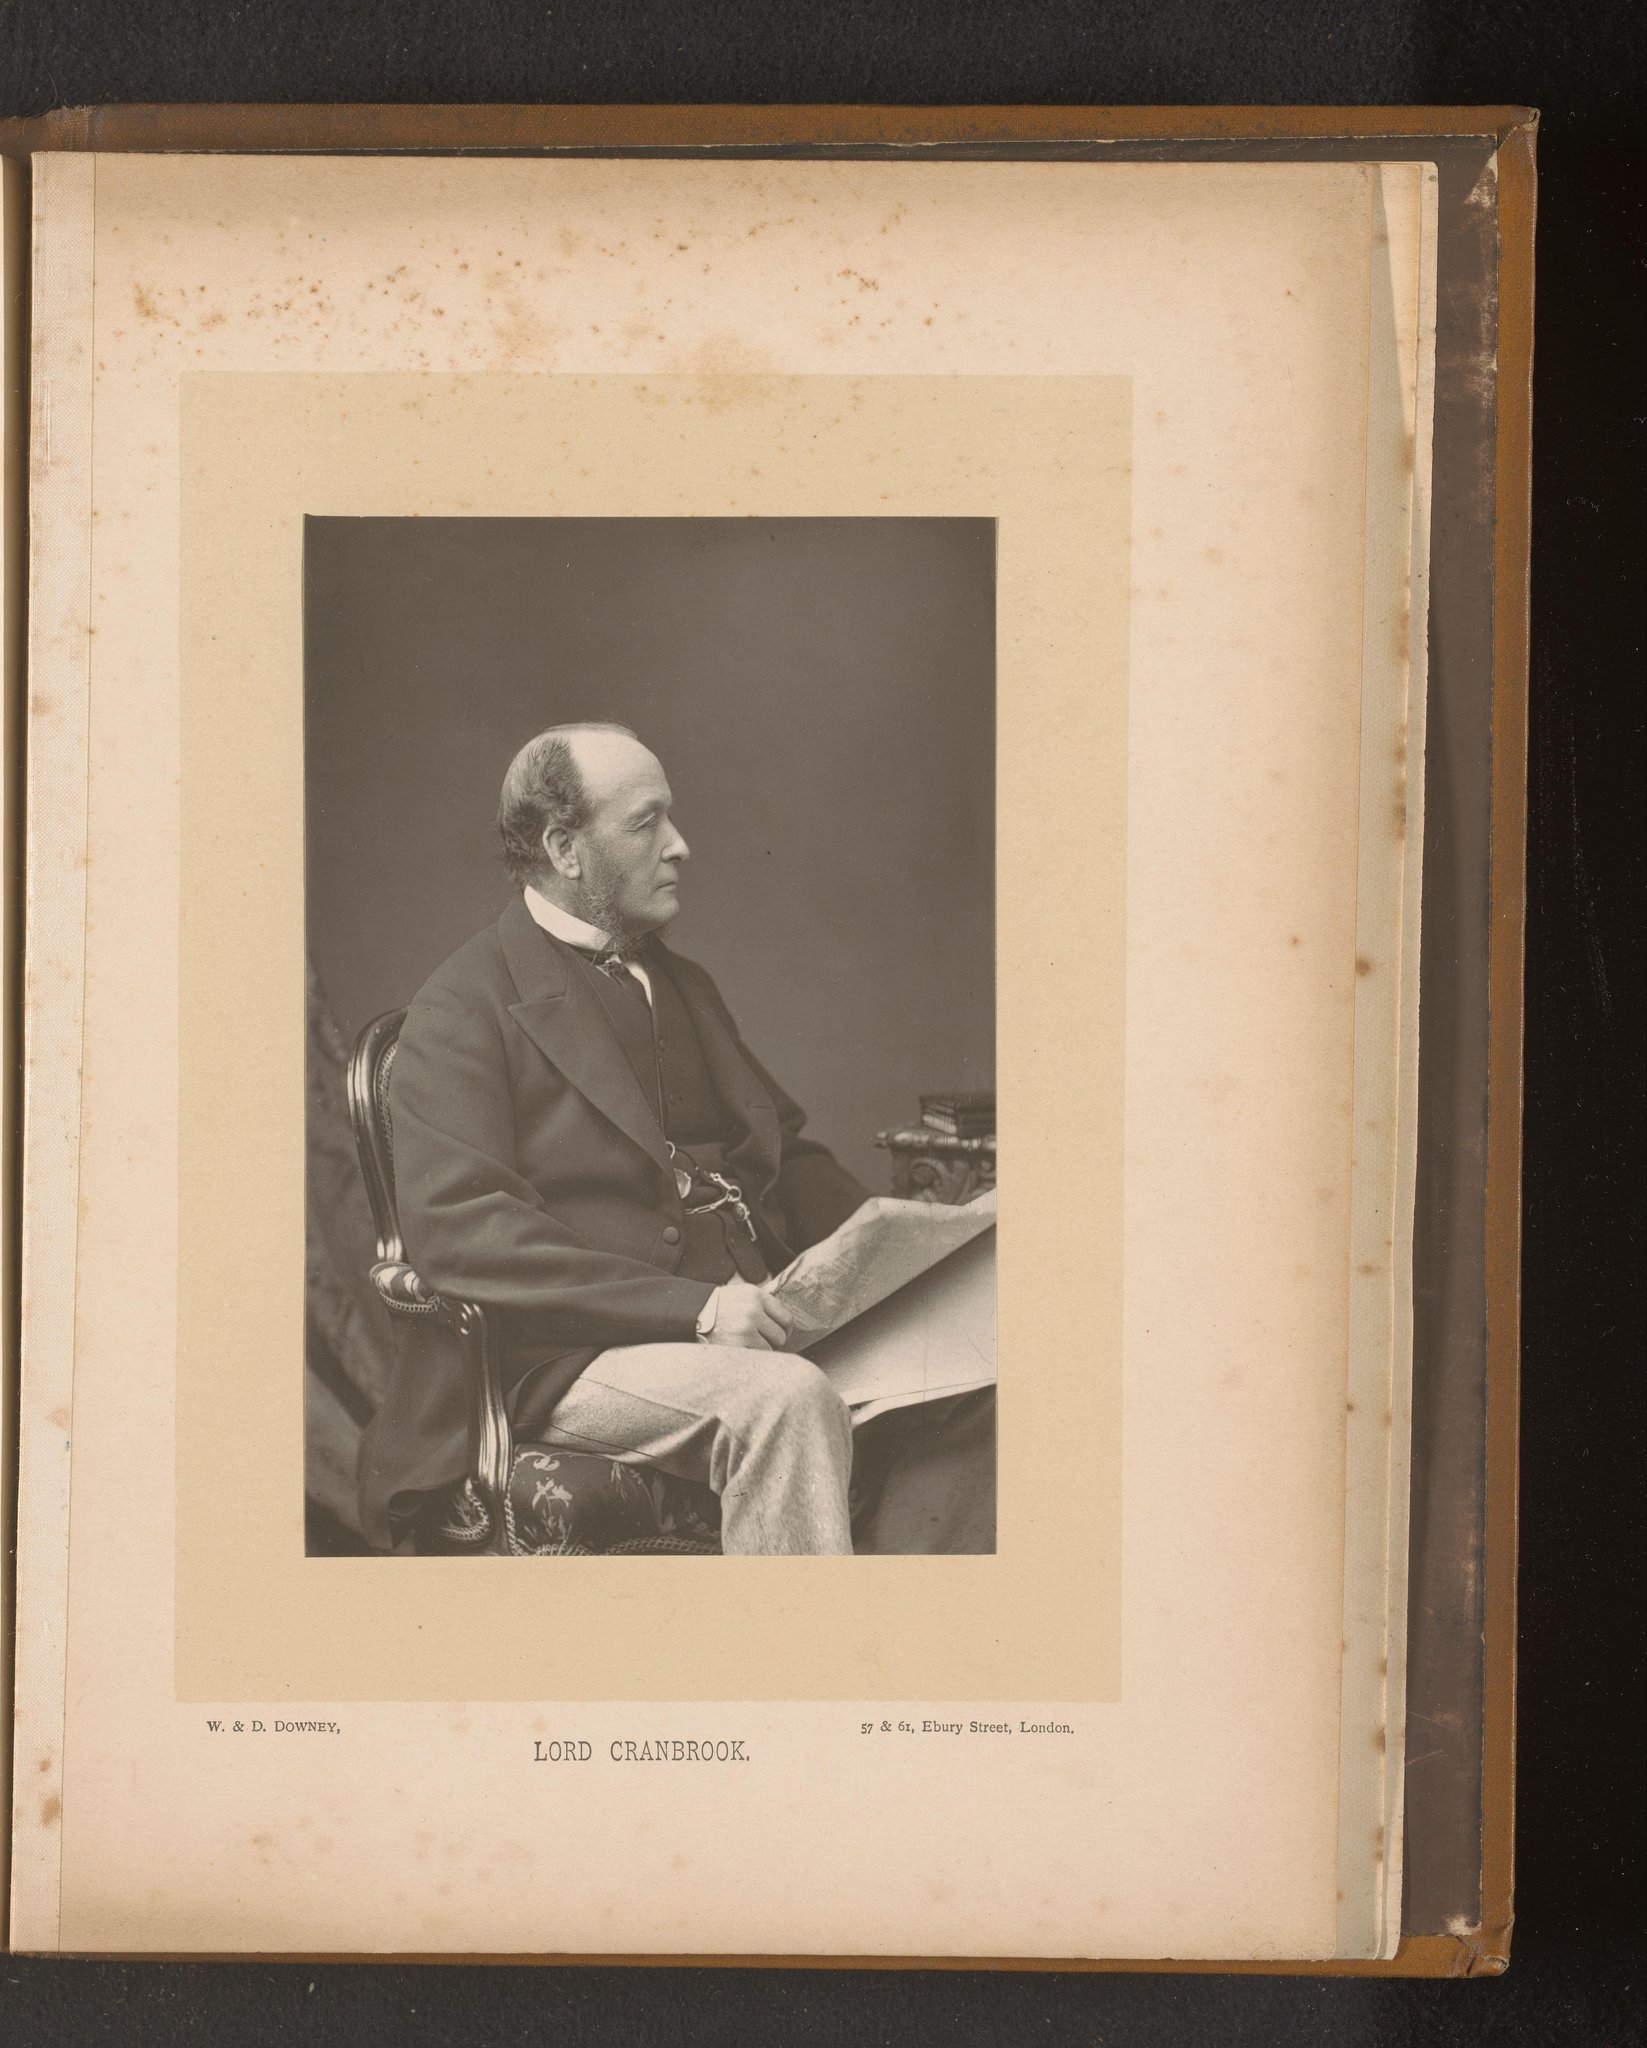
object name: page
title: Lord Cranbrook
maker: Anonymous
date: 1881-1891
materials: paper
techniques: woodburytype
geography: london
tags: politician, e.g. party leader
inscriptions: inscription: ‘57 & 61, Elbury Street, London.’